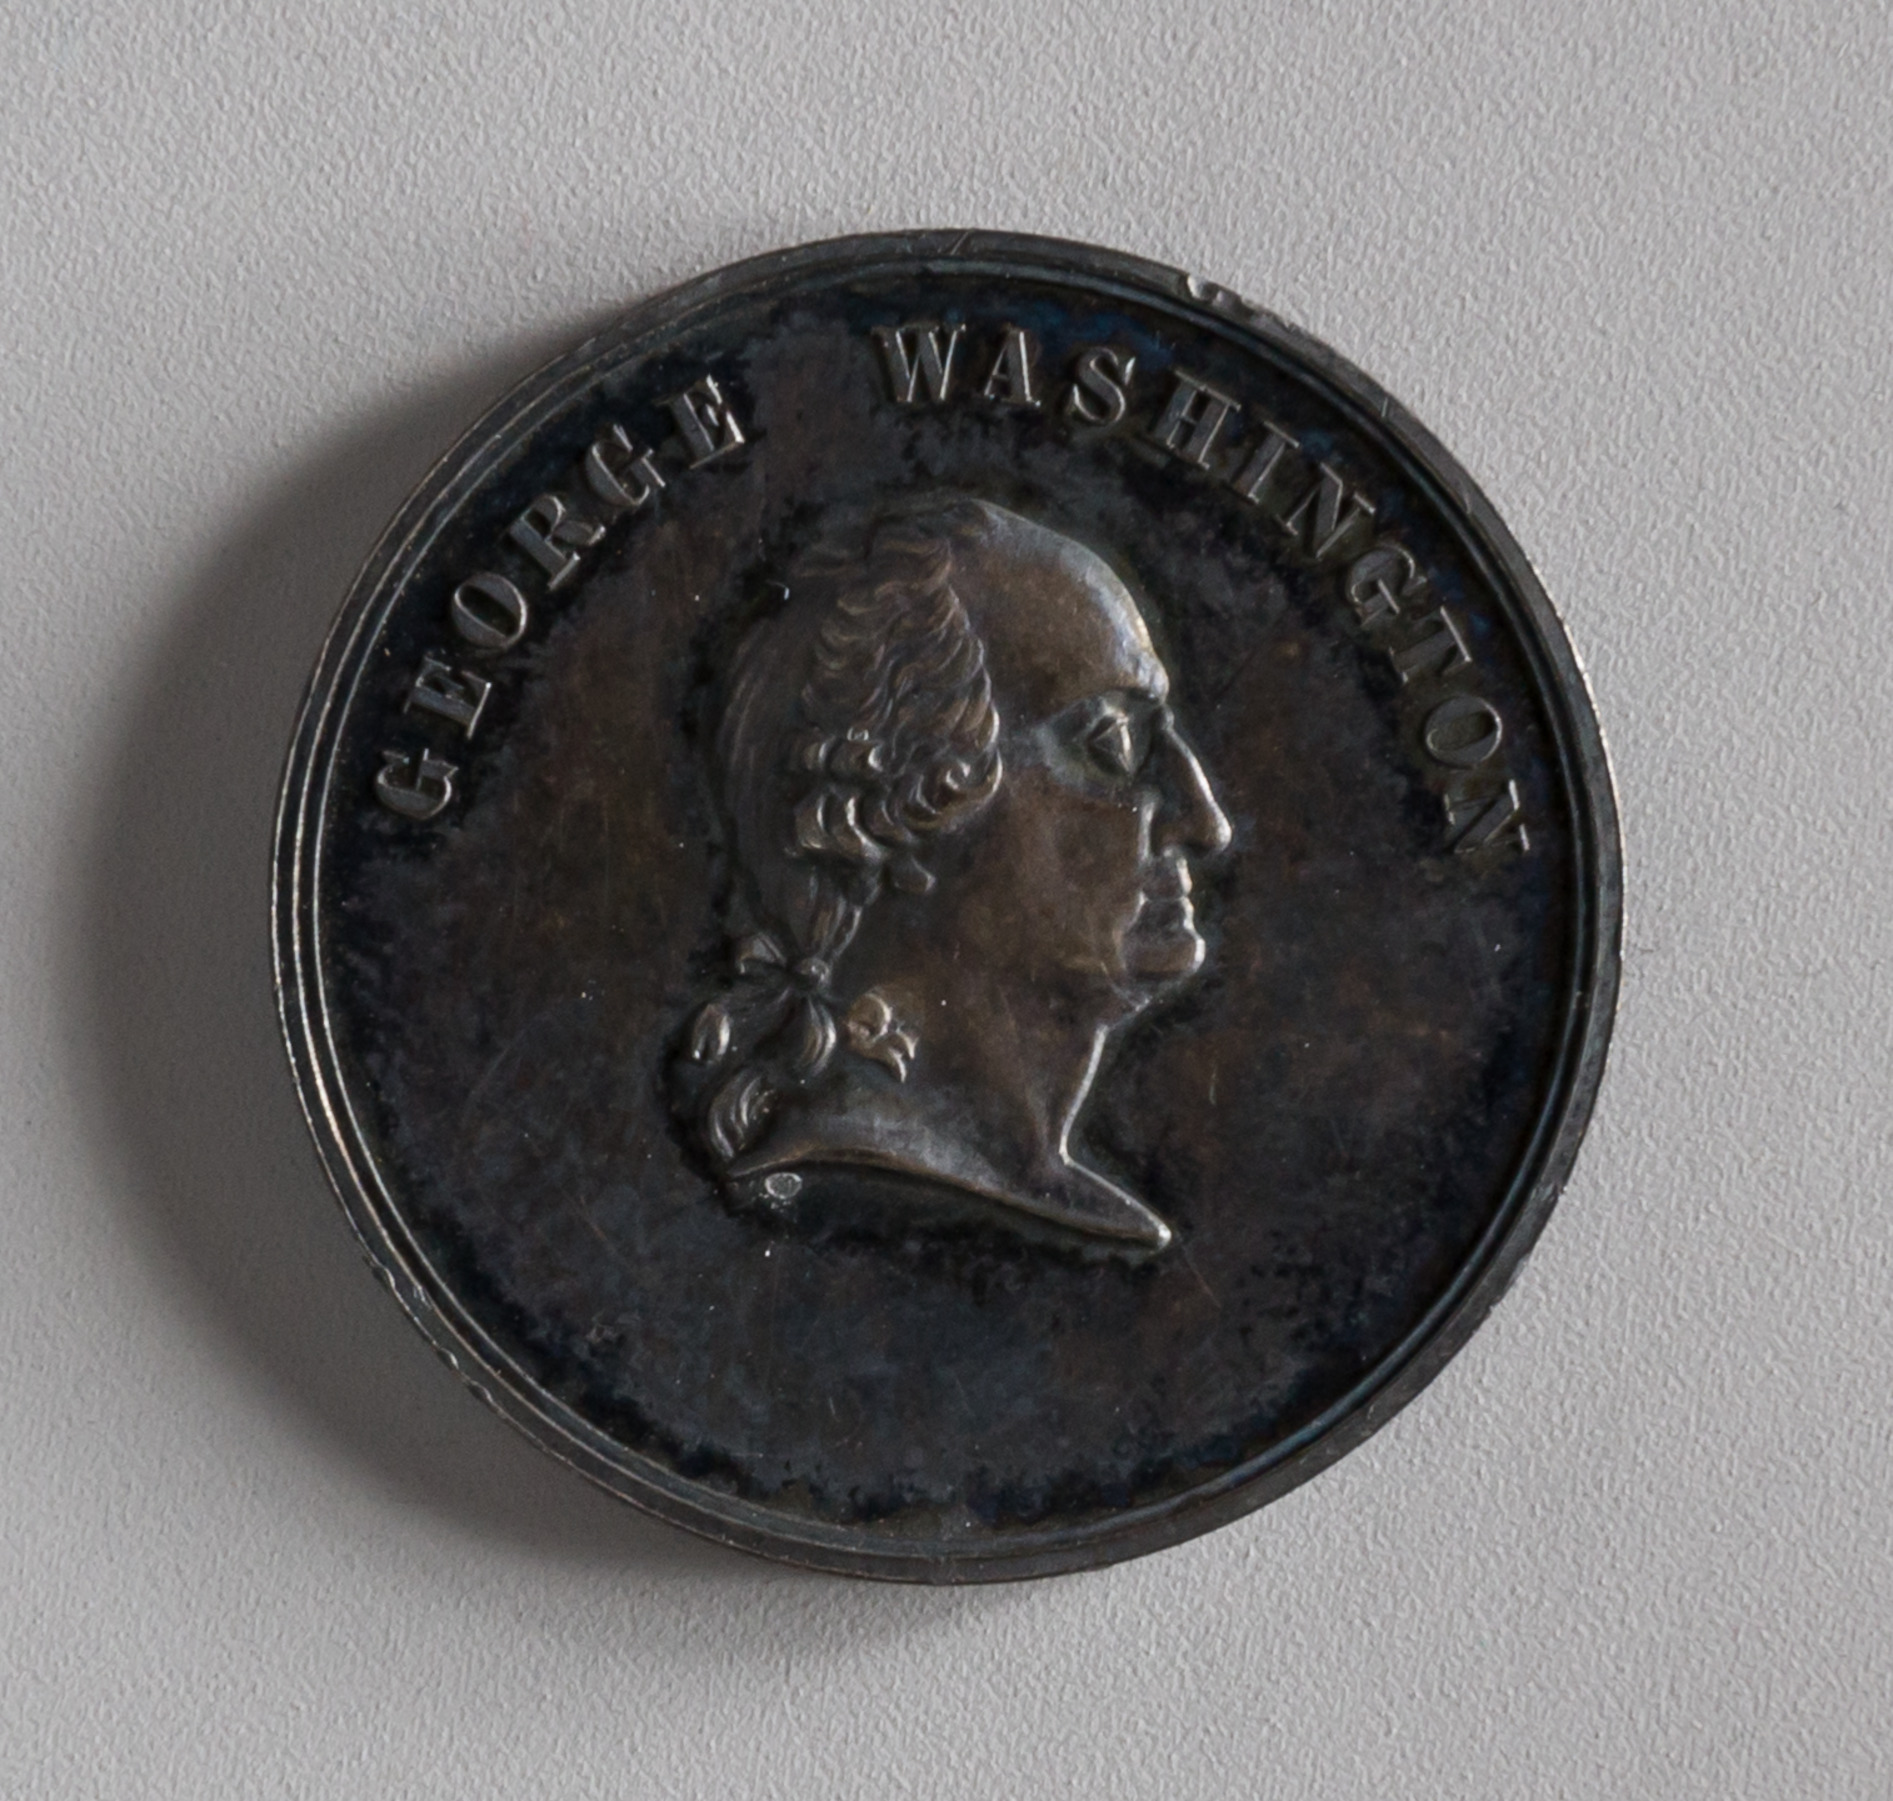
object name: medal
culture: american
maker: william kneass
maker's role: maker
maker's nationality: american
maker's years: 1781-1840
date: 1823-1840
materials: silver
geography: united states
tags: george washington,profiles